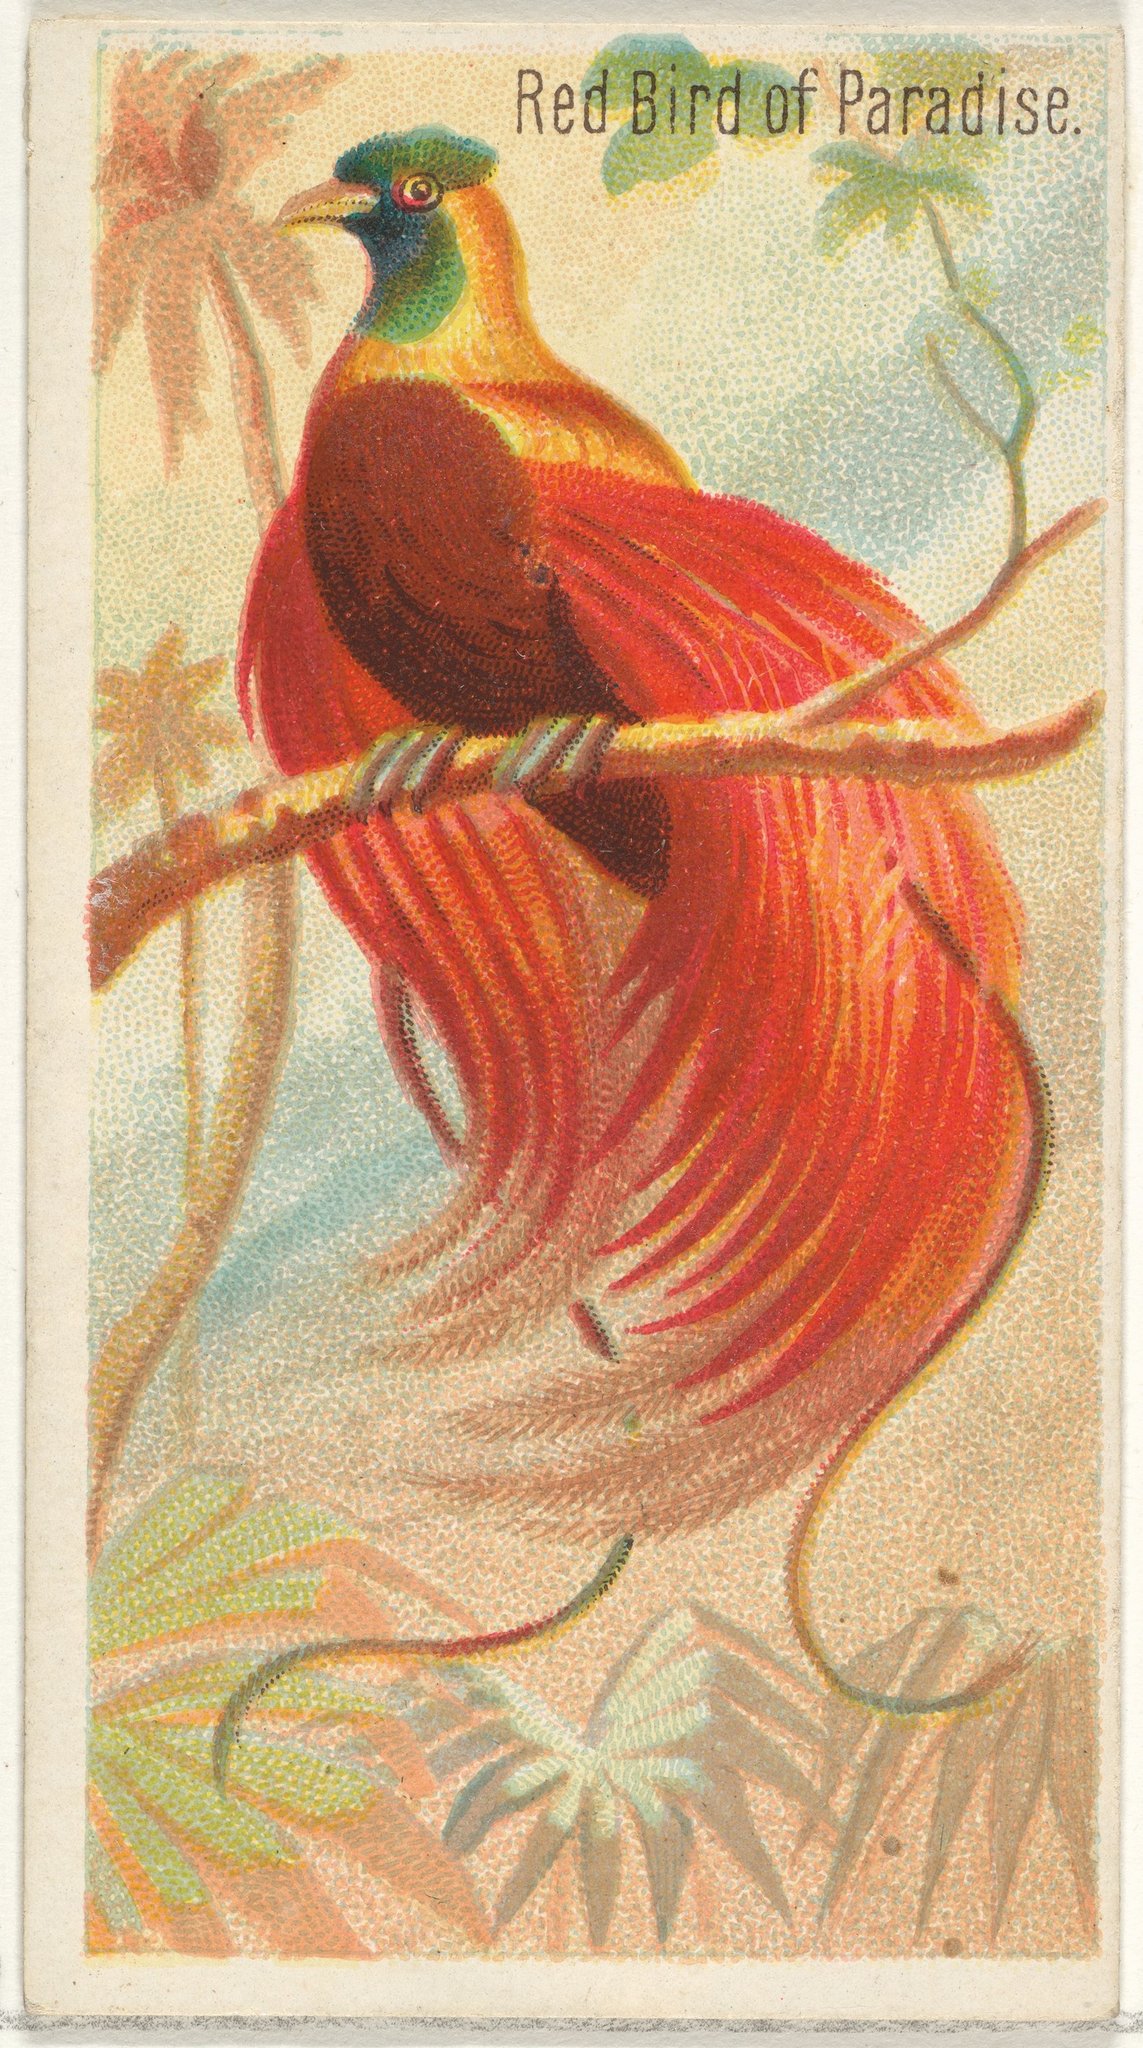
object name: print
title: Red Bird of Paradise, from the Birds of the Tropics series (N5) for Allen & Ginter Cigarettes Brands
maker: allen & ginter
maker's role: publisher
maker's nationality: american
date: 1889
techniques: color lithograph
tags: birds